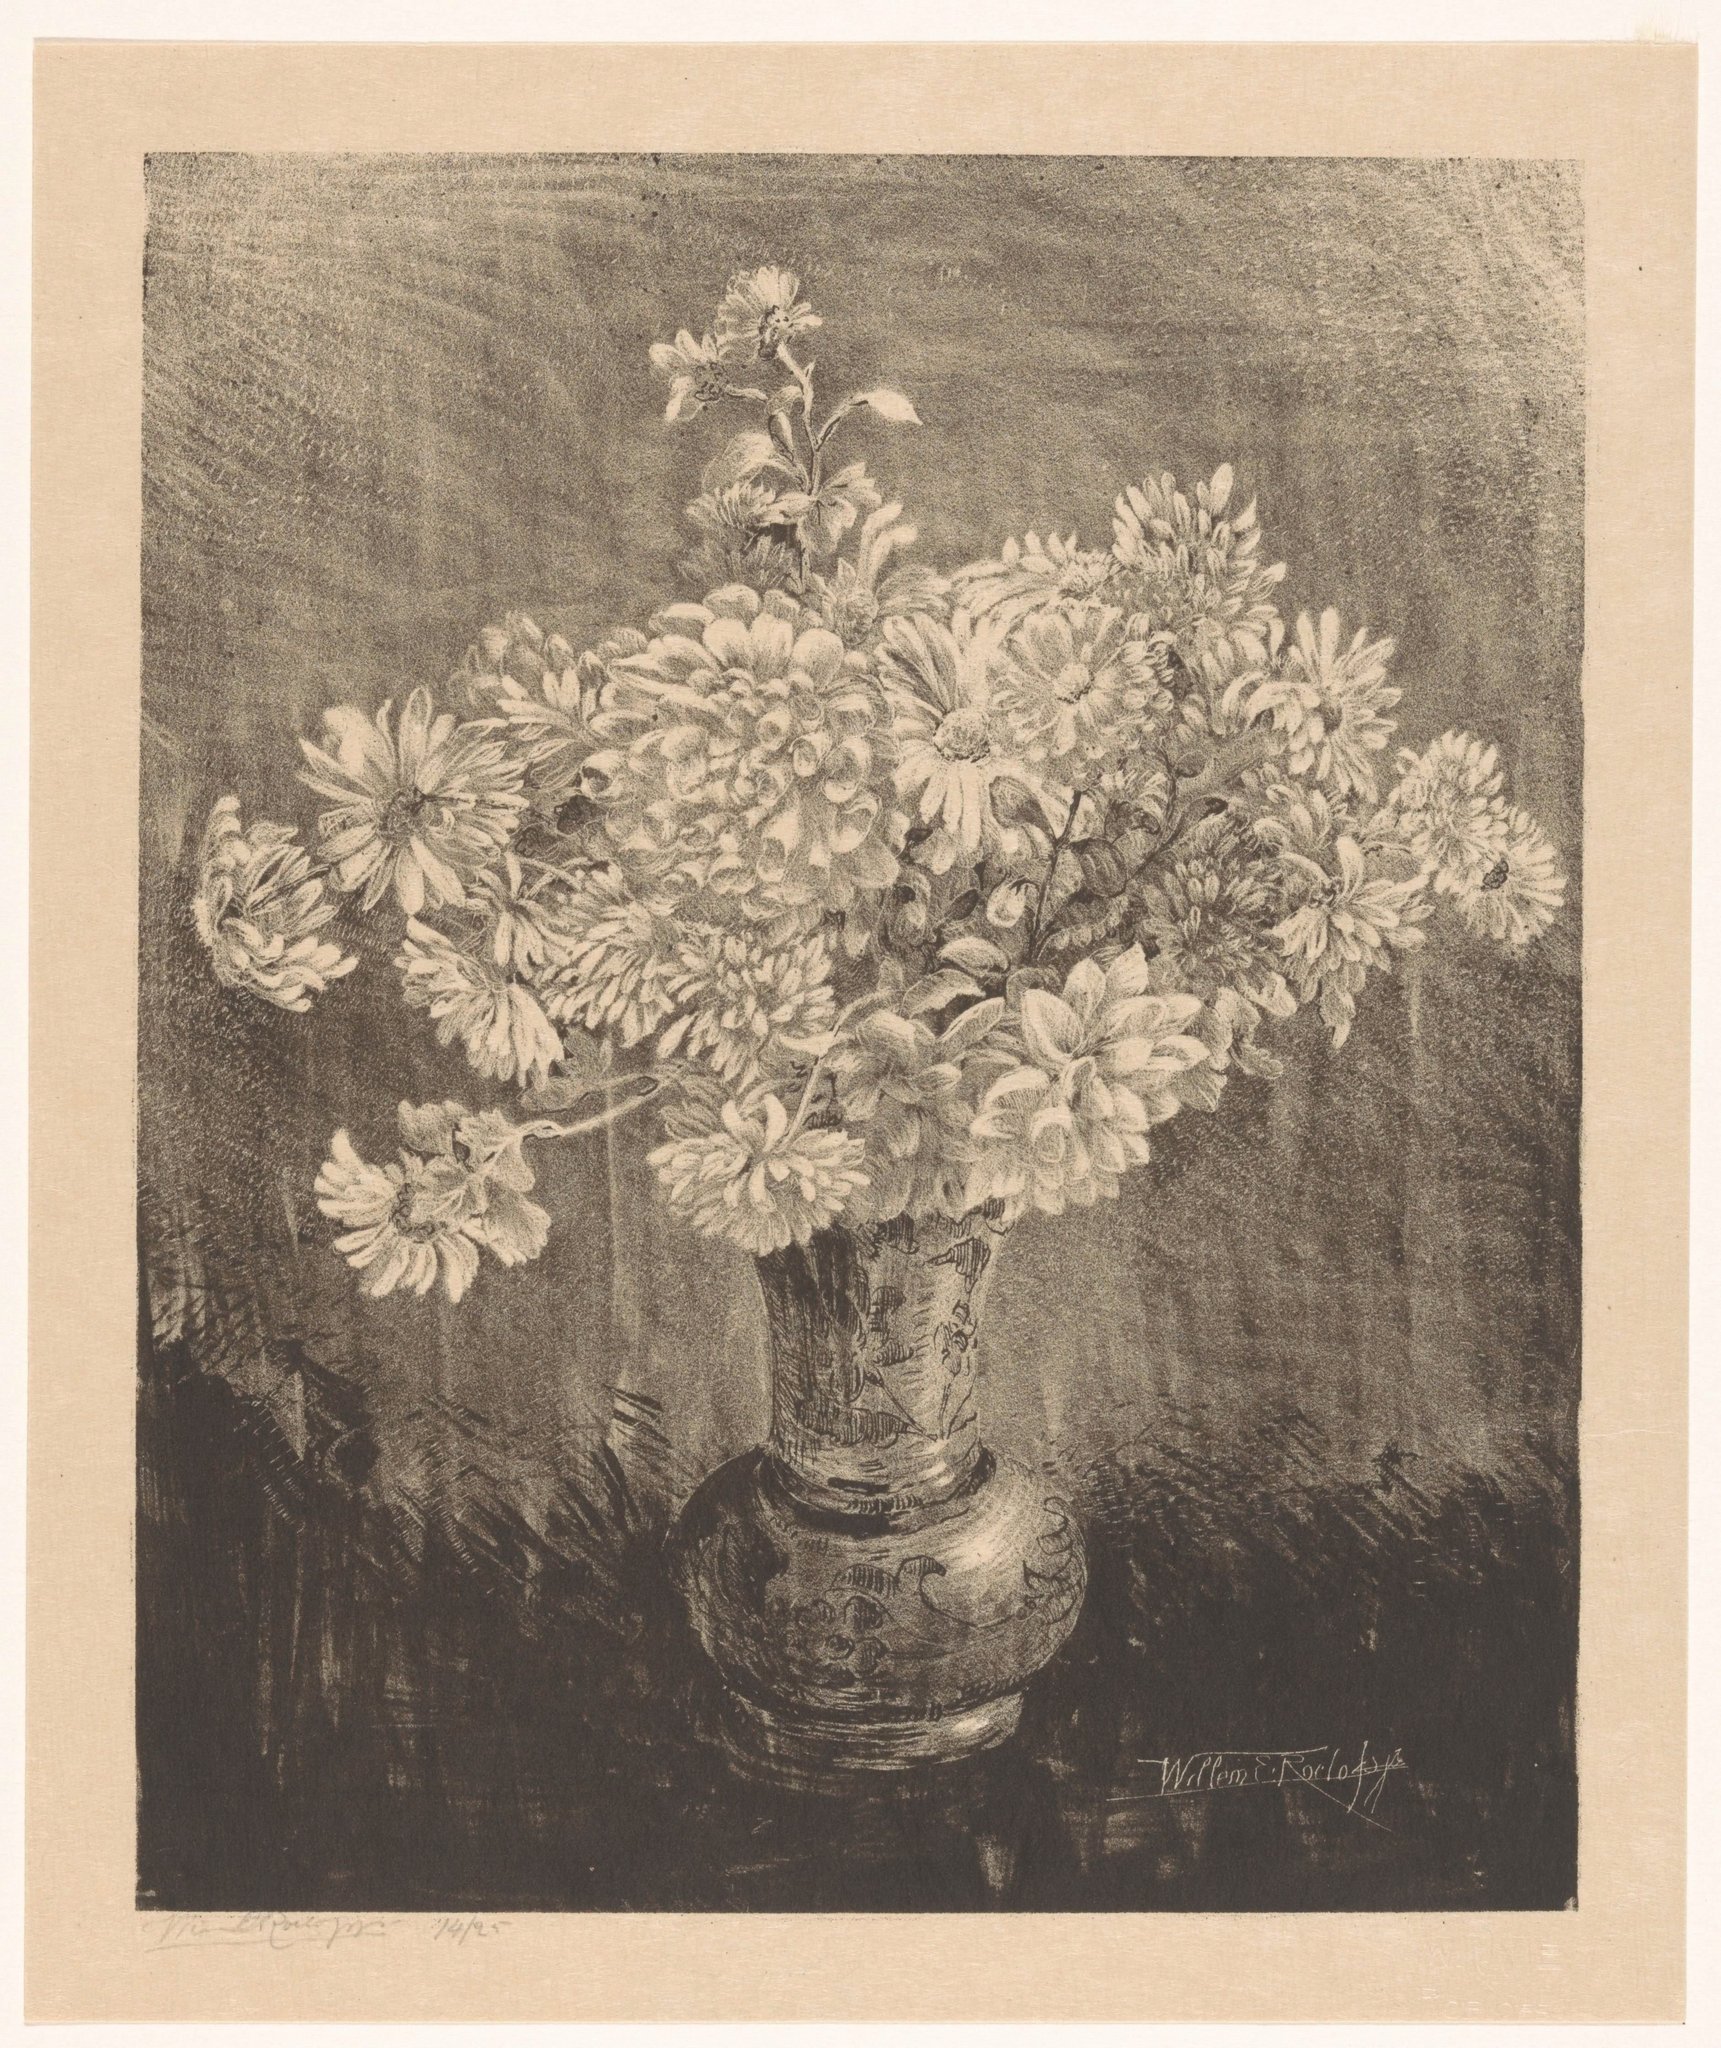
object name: print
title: Chrysanten in een vaas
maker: willem roelofs (ii)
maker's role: draughtsman, painter, print maker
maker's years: 1874-1940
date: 1884-1931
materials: paper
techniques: lithograph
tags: flowers in a vase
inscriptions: collector's mark: Lugt 2228